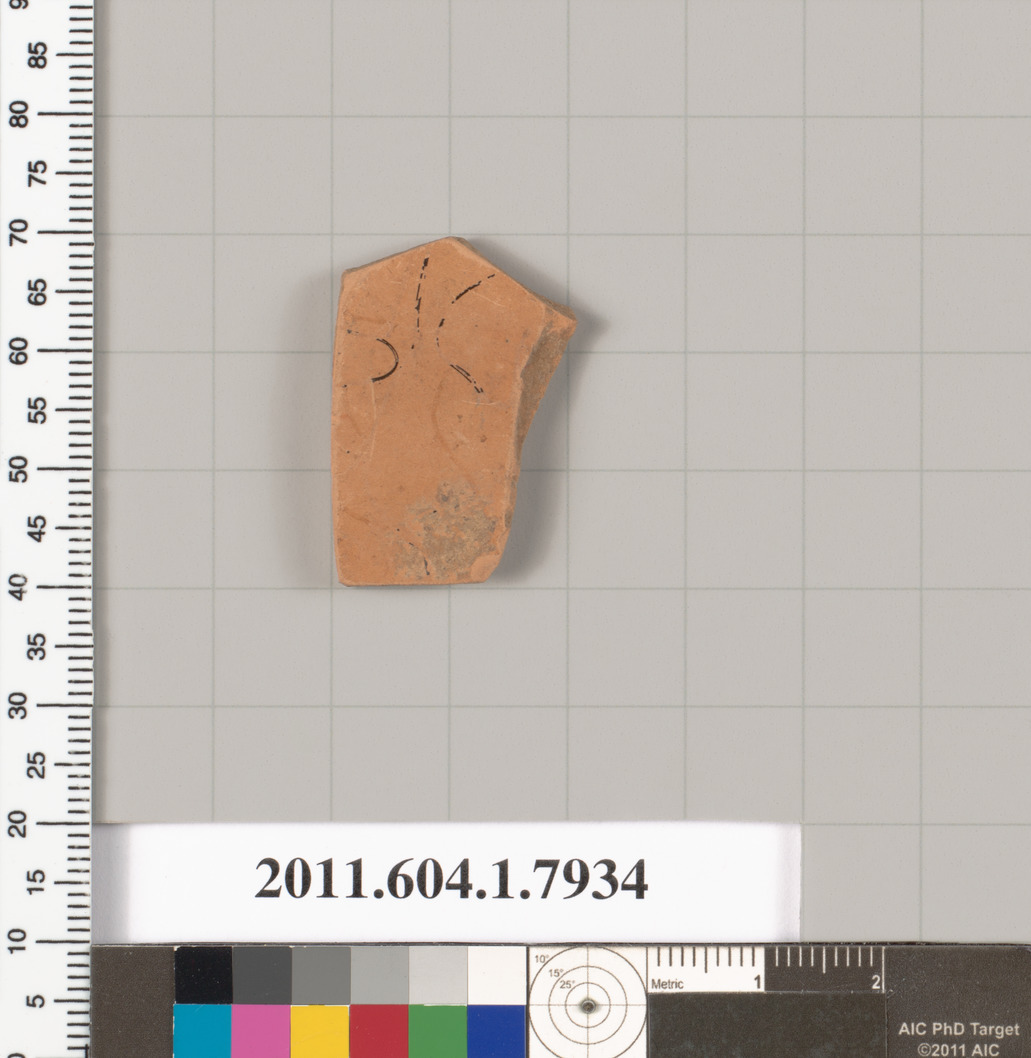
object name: kylix fragment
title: Terracotta fragment of a kylix (drinking cup)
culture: greek, attic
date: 460-450 BCE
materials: terracotta